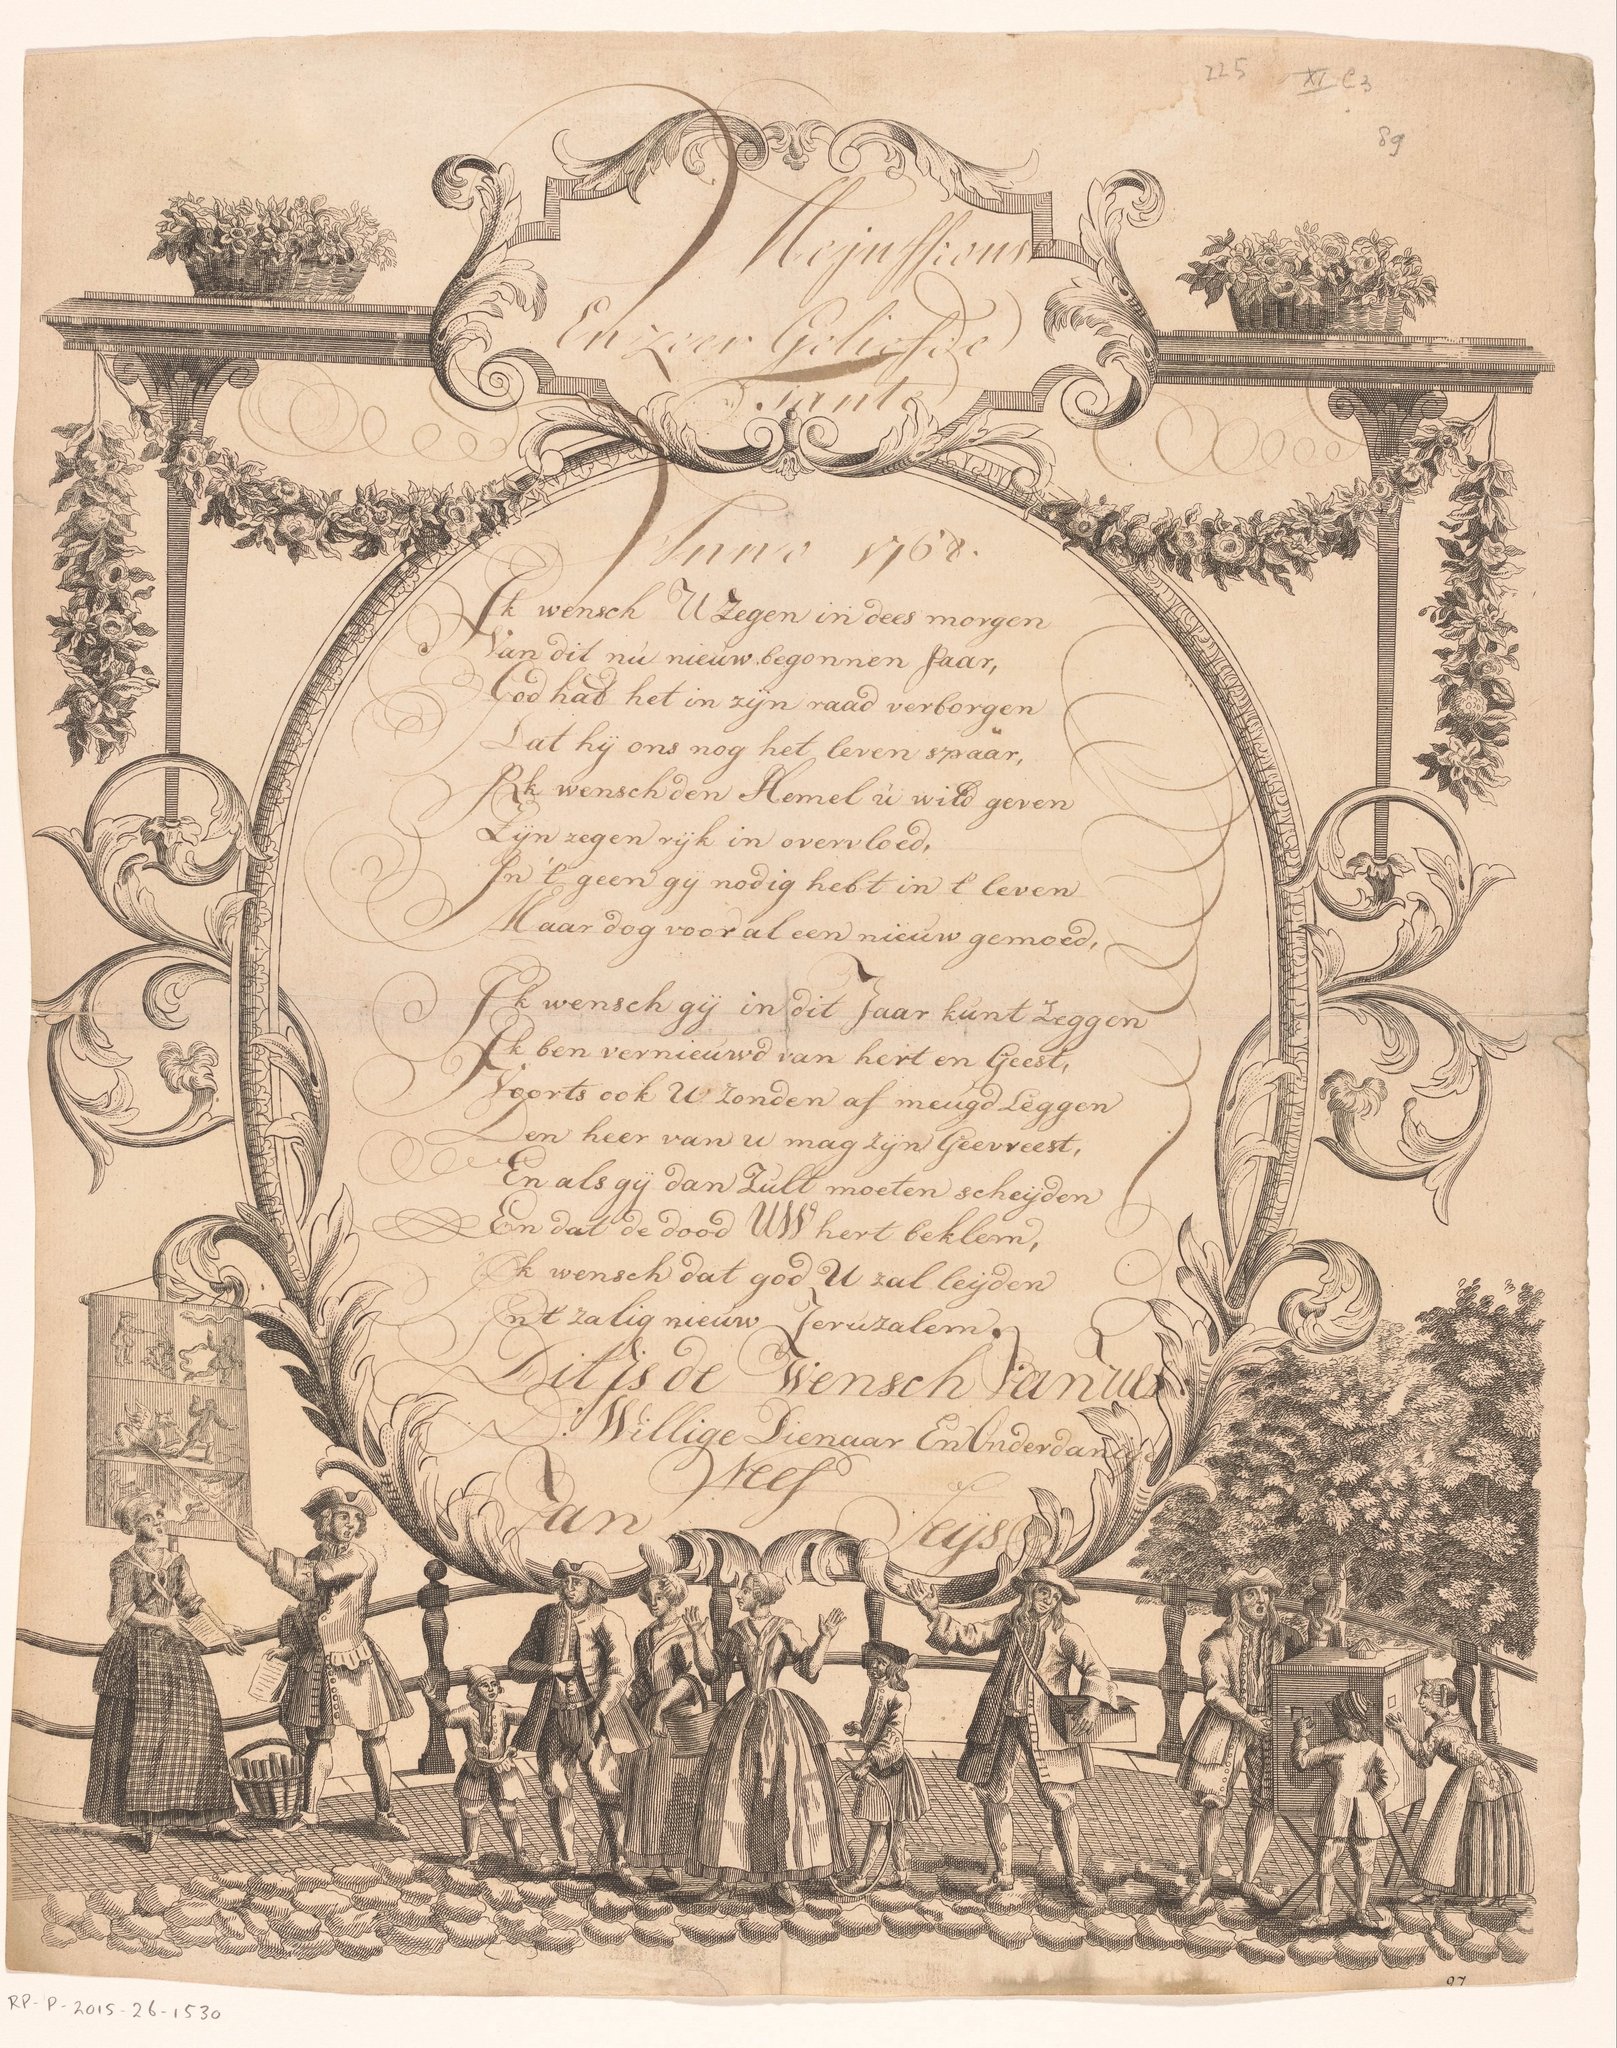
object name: print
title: Wensbrief met activiteiten op straat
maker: Anonymous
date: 1768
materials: ink, paper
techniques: calligraphy, etching, pen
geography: netherlands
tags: vocal music, singing - cc - out of doors, peep-show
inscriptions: collector's mark: Lugt 2228, collector's mark: Lugt 4779, inscription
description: Wensbrief met beschreven cartouche binnen een decoratief kader met voorstellingen van activiteiten op straat, zoals mensen die straatliederen zingen en kinderen die in een kijkkast gluren. Handgeschreven nieuwjaarswens door Jan Seijs aan zijn tante. Linksonder genummerd: 97.